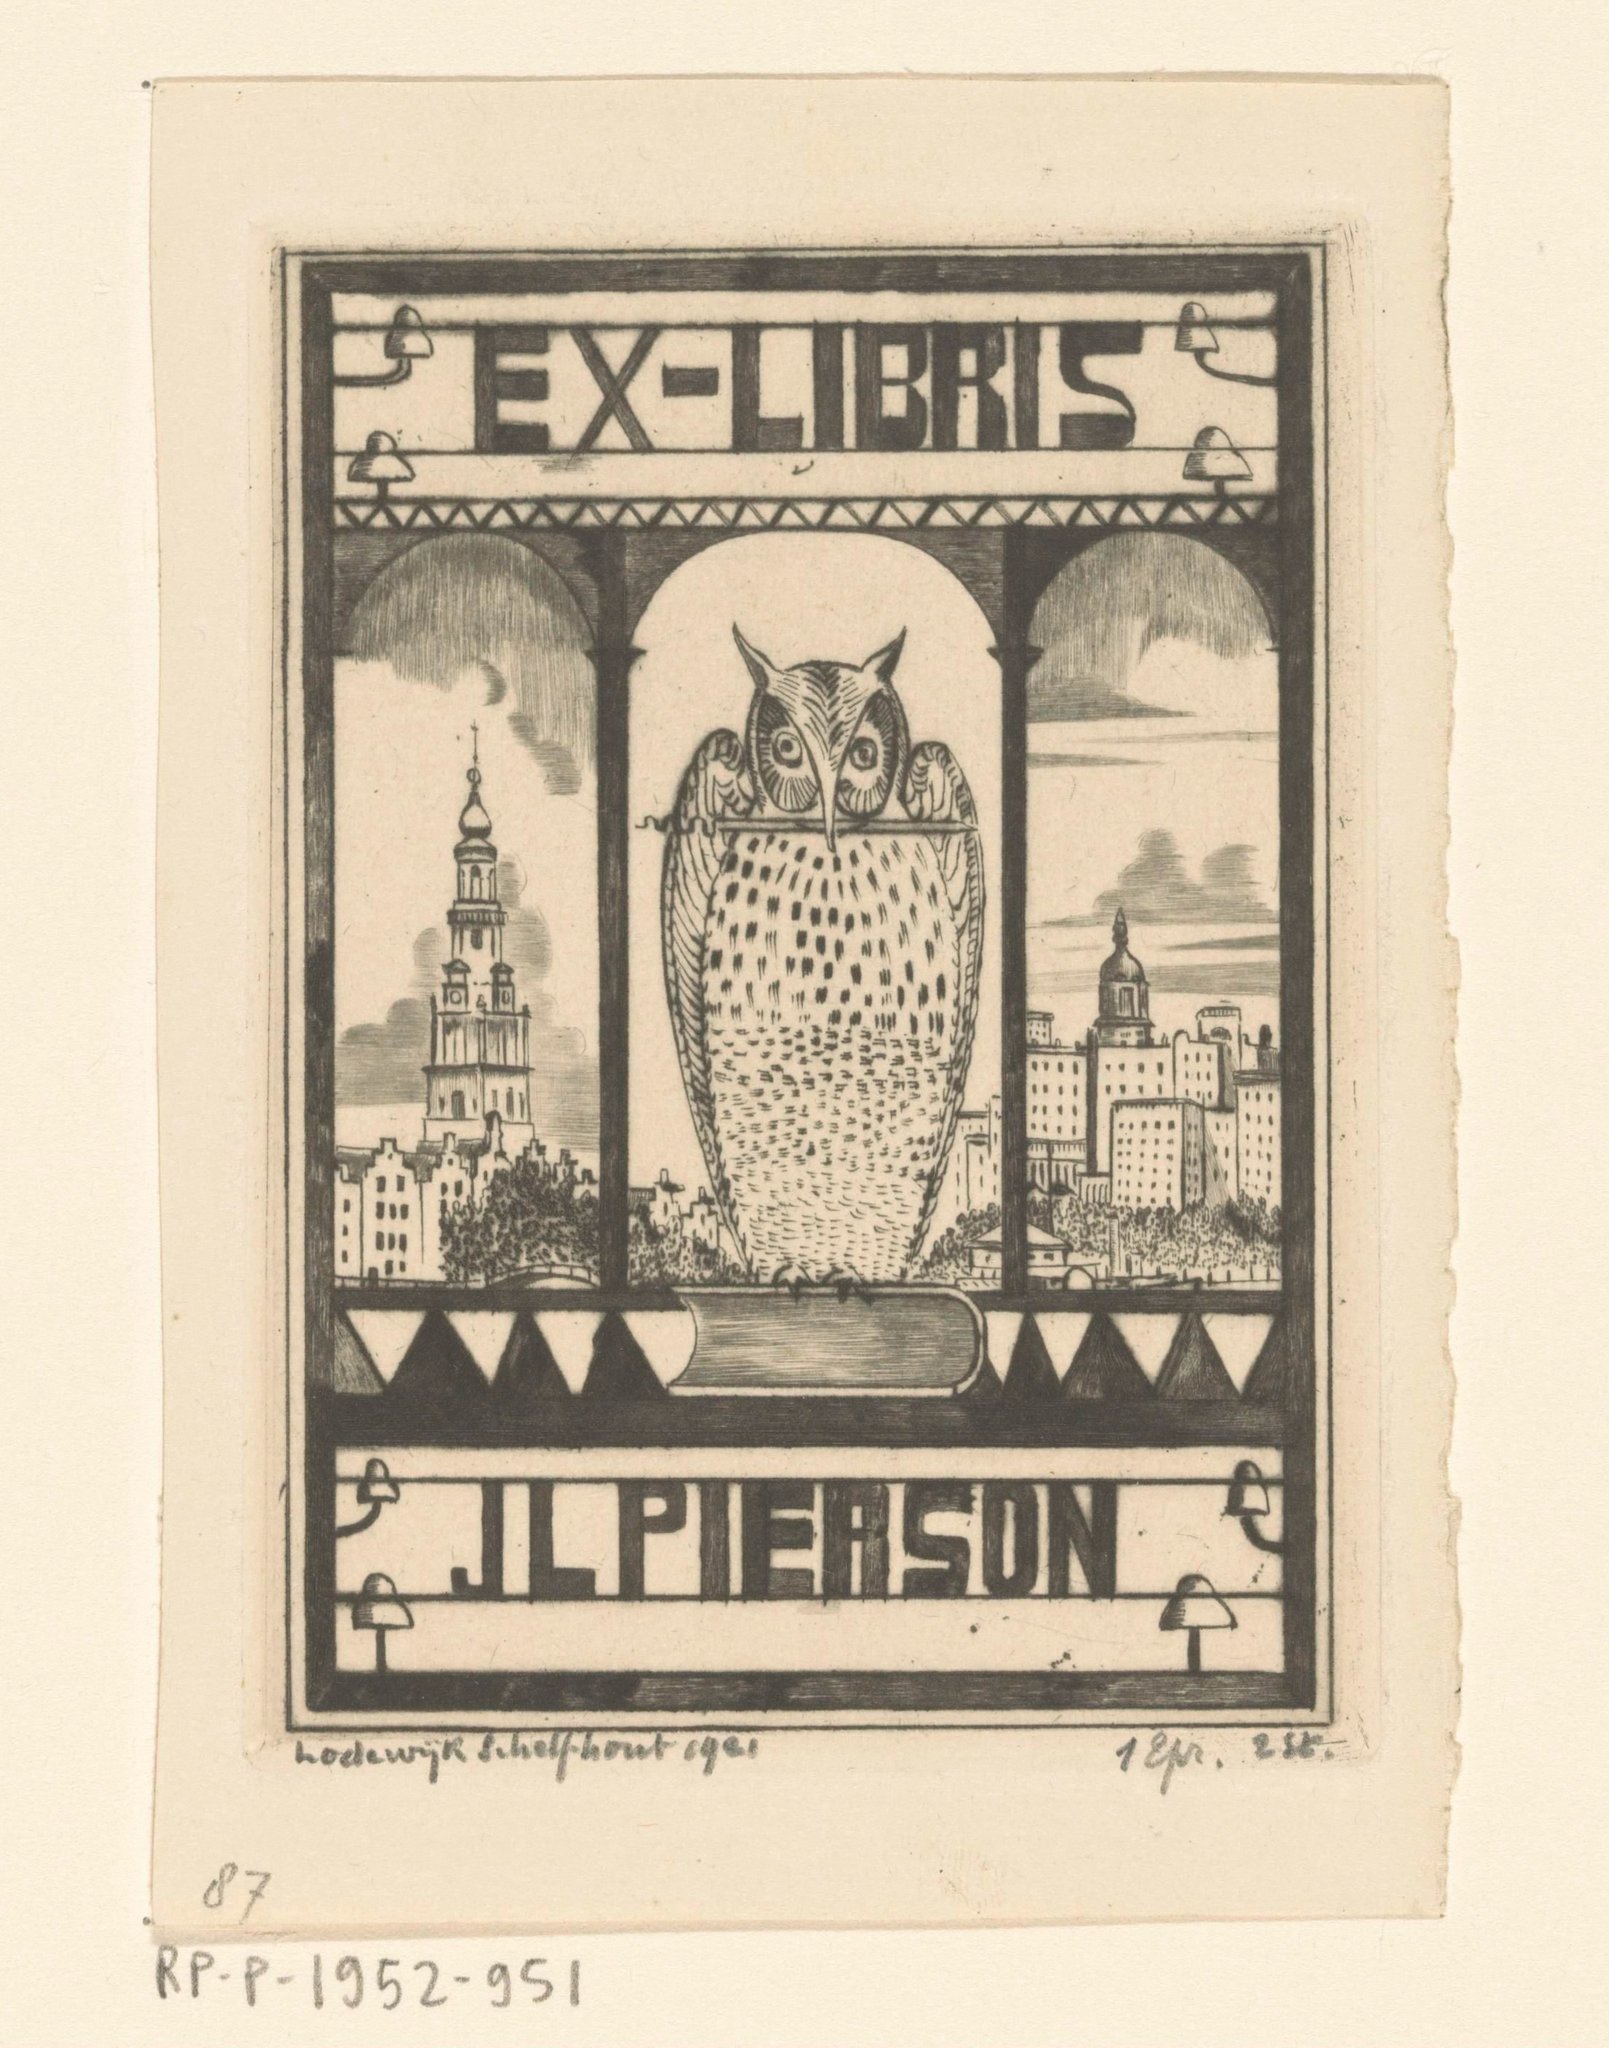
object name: bookplate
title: Ex libris van J.L. Pierson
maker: lodewijk schelfhout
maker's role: draughtsman, print maker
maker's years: 1881-1943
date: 1921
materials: paper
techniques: drypoint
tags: view through a window, pen, book, owls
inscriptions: collector's mark: Lugt 2228, collector's mark: Lugt 2760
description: Een uil met een pen in zijn snavel, zittend op een boek. Op de achtergrond zicht op een stad door drie boogvensters.